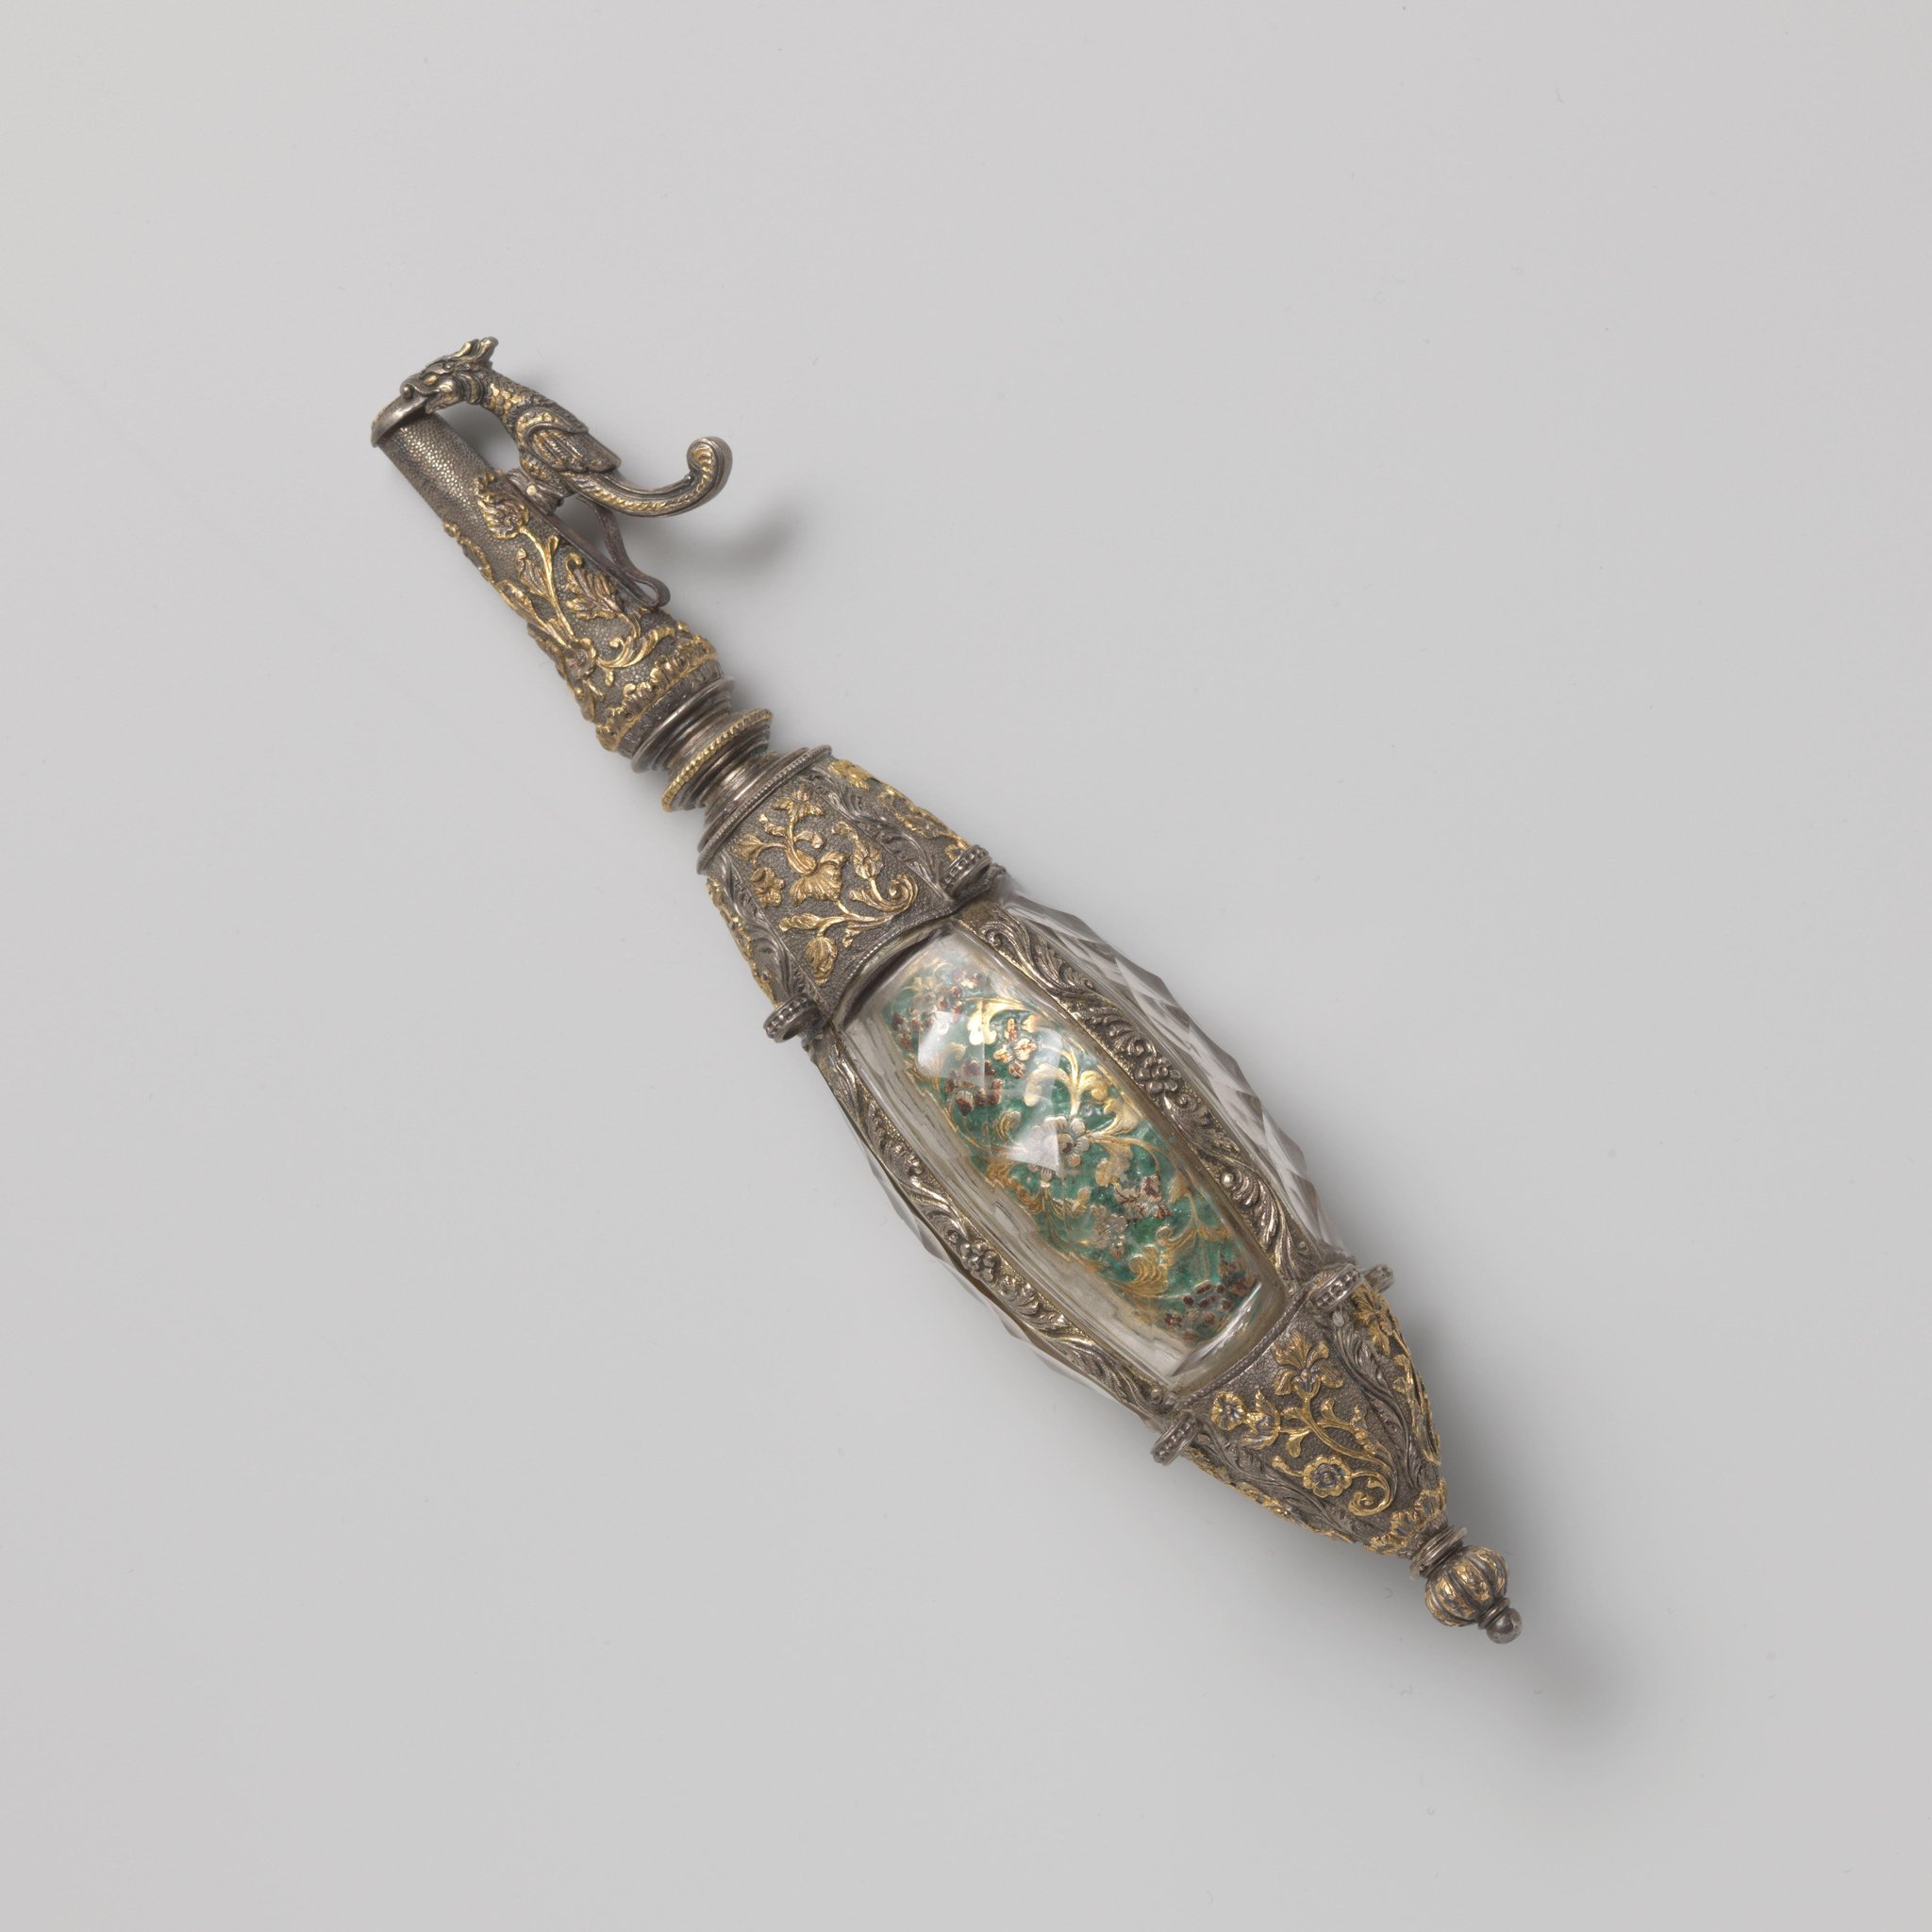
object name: powder horn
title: Sieraad van zilver met gouden drijfwerk met een buik van geslepen glas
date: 1700-1800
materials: glass, silver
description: Sieraad van zilver met gouden drijfwerk. De buik van geslepen glas, waardoor een tweede koker te zien is van groen en bruin email. Kettingen ontbreken.